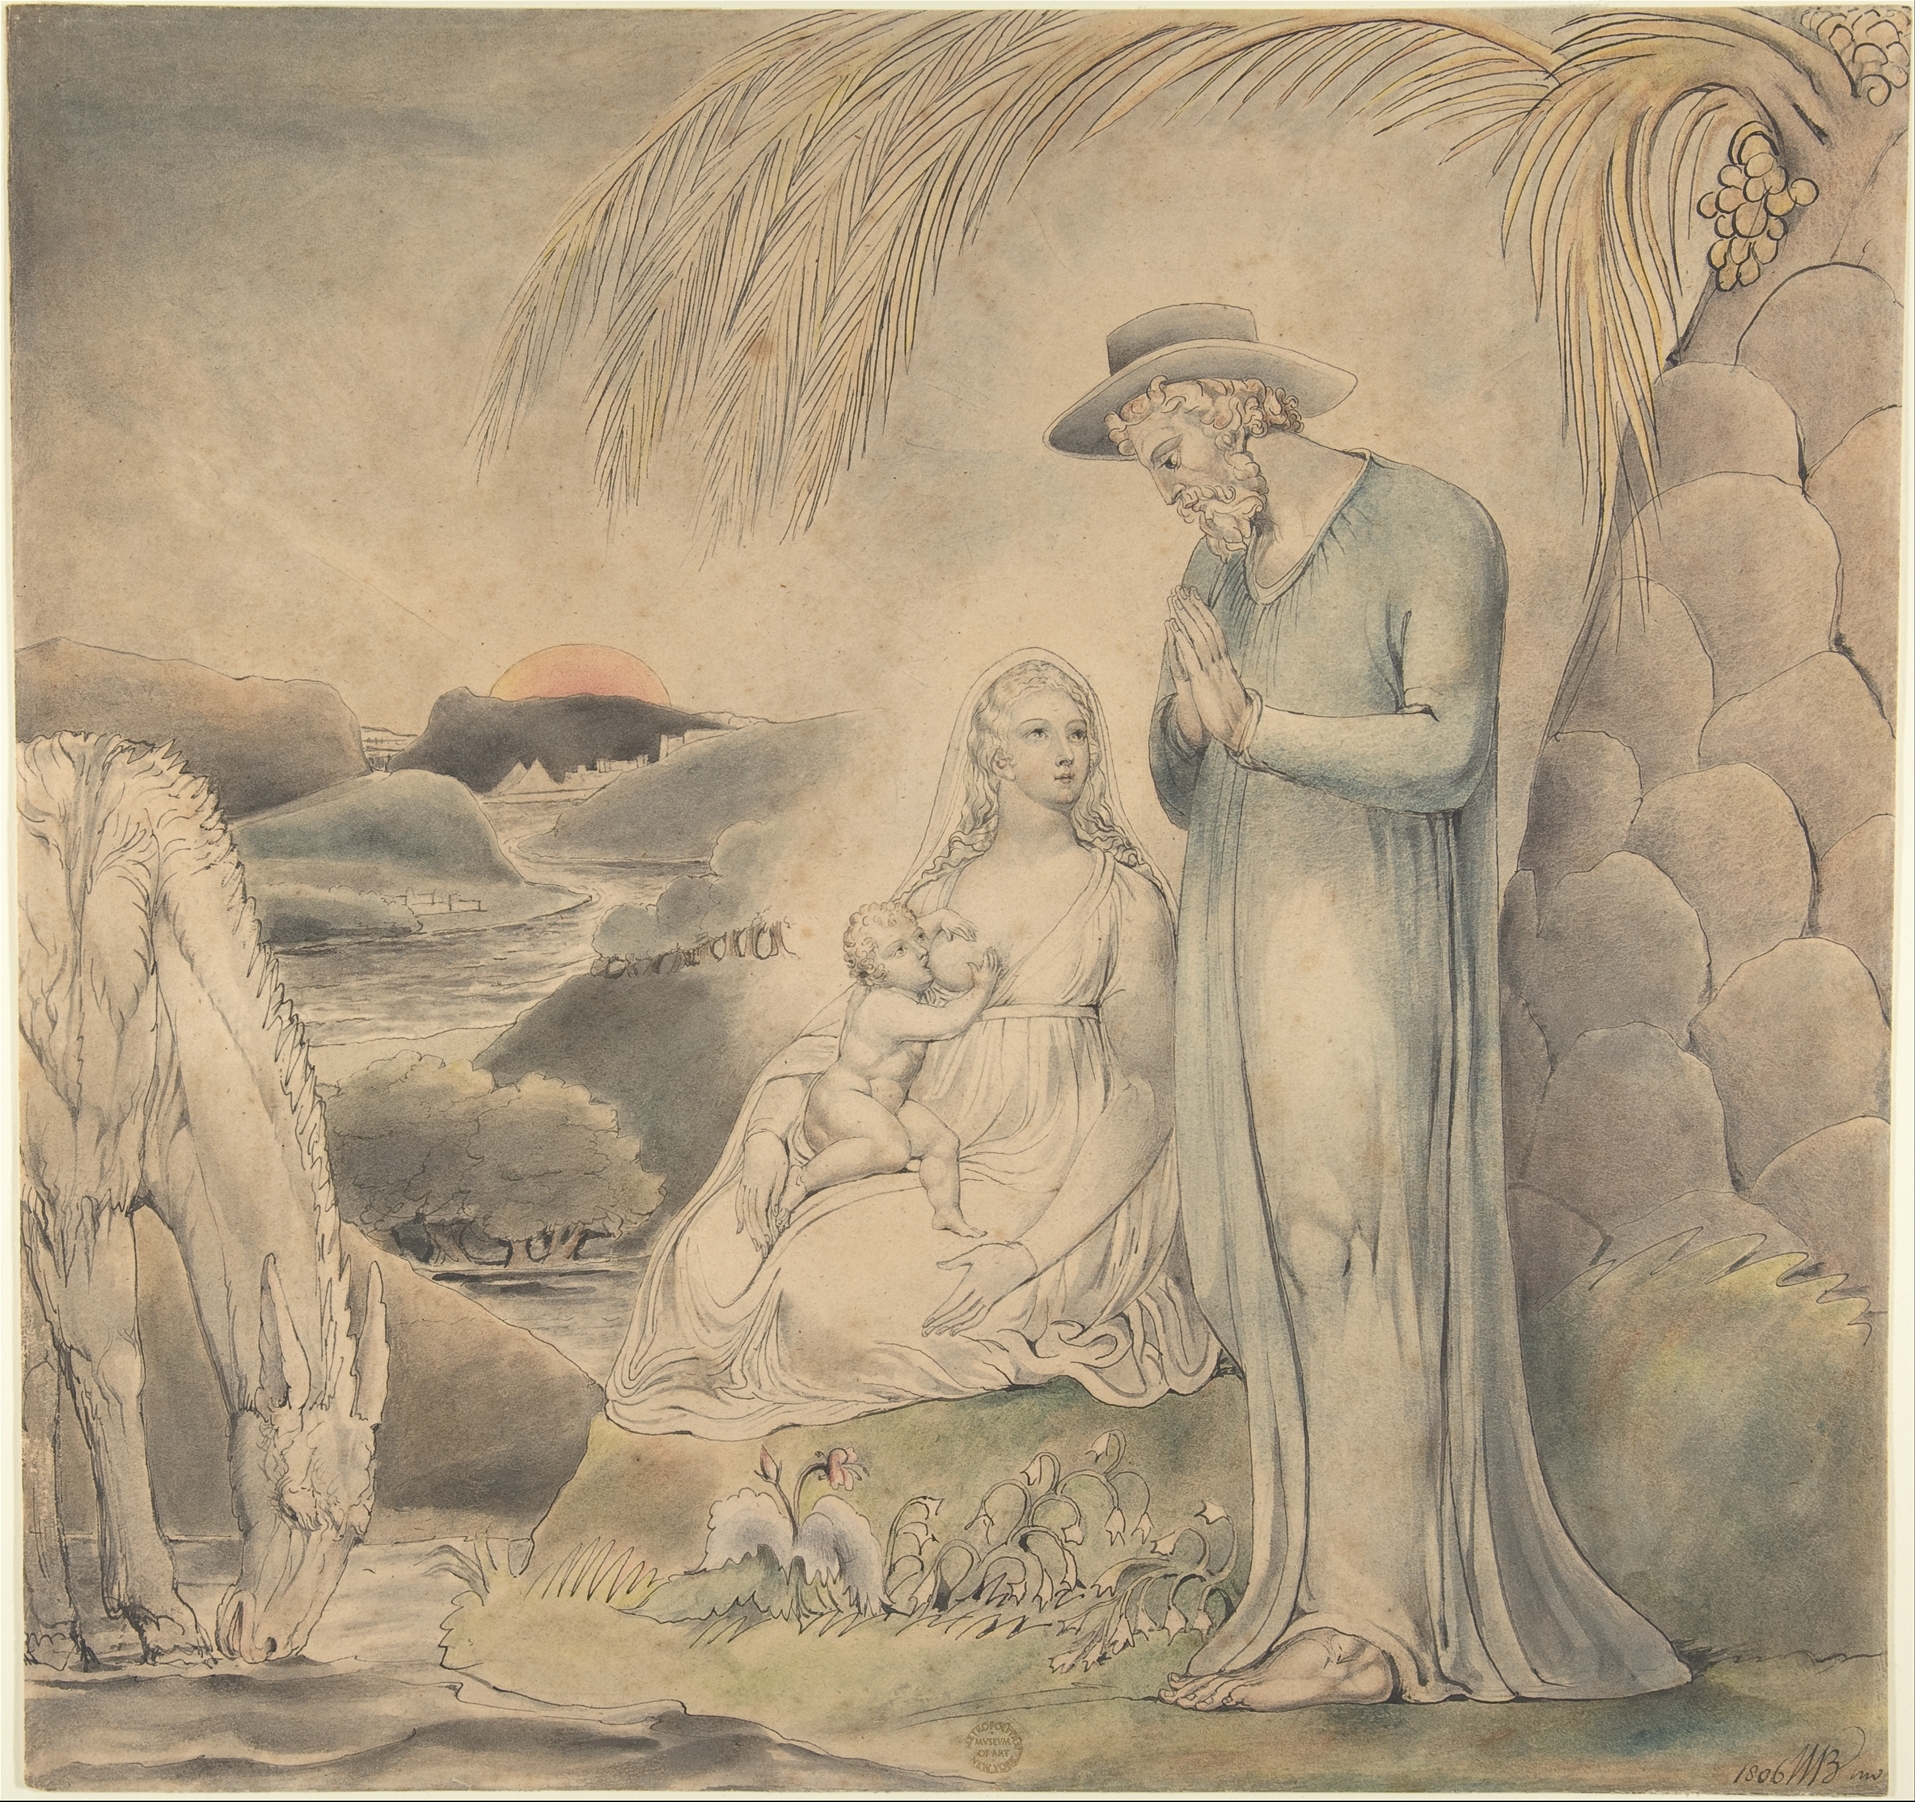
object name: drawing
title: The Rest on the Flight into Egypt (The Repose of the Holy Family in Egypt)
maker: william blake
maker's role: artist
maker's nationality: british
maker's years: 1757-1827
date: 1806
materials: graphite, ink, watercolor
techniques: pen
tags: animals,sun,landscapes,trees,holy family